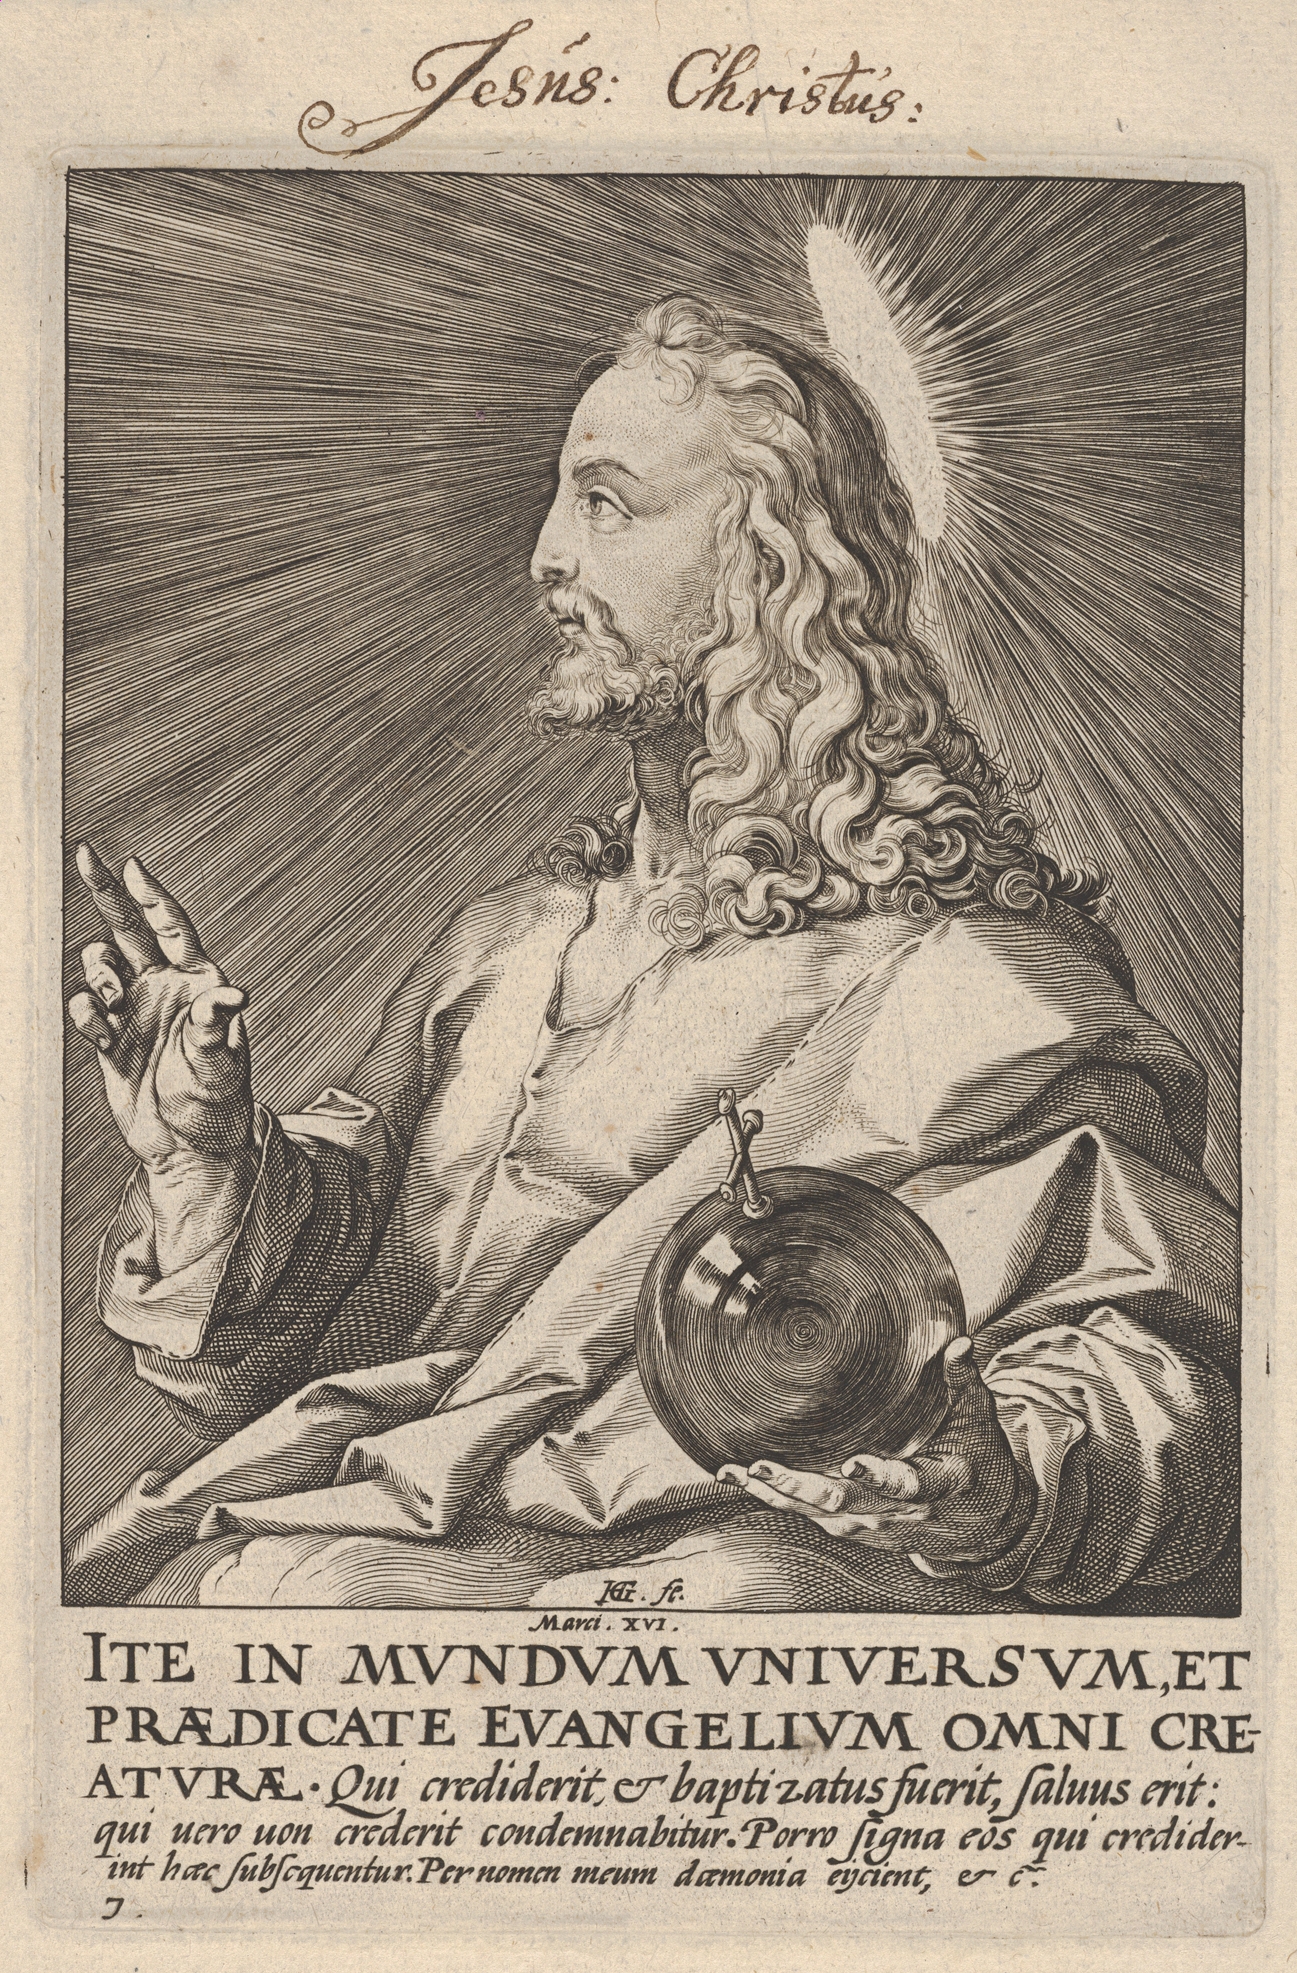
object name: print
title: Christ, from "Christ, the Apostles and St. Paul with the Creed"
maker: hendrick goltzius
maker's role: artist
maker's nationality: netherlandish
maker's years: 1558-1617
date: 1589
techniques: engraving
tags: christ